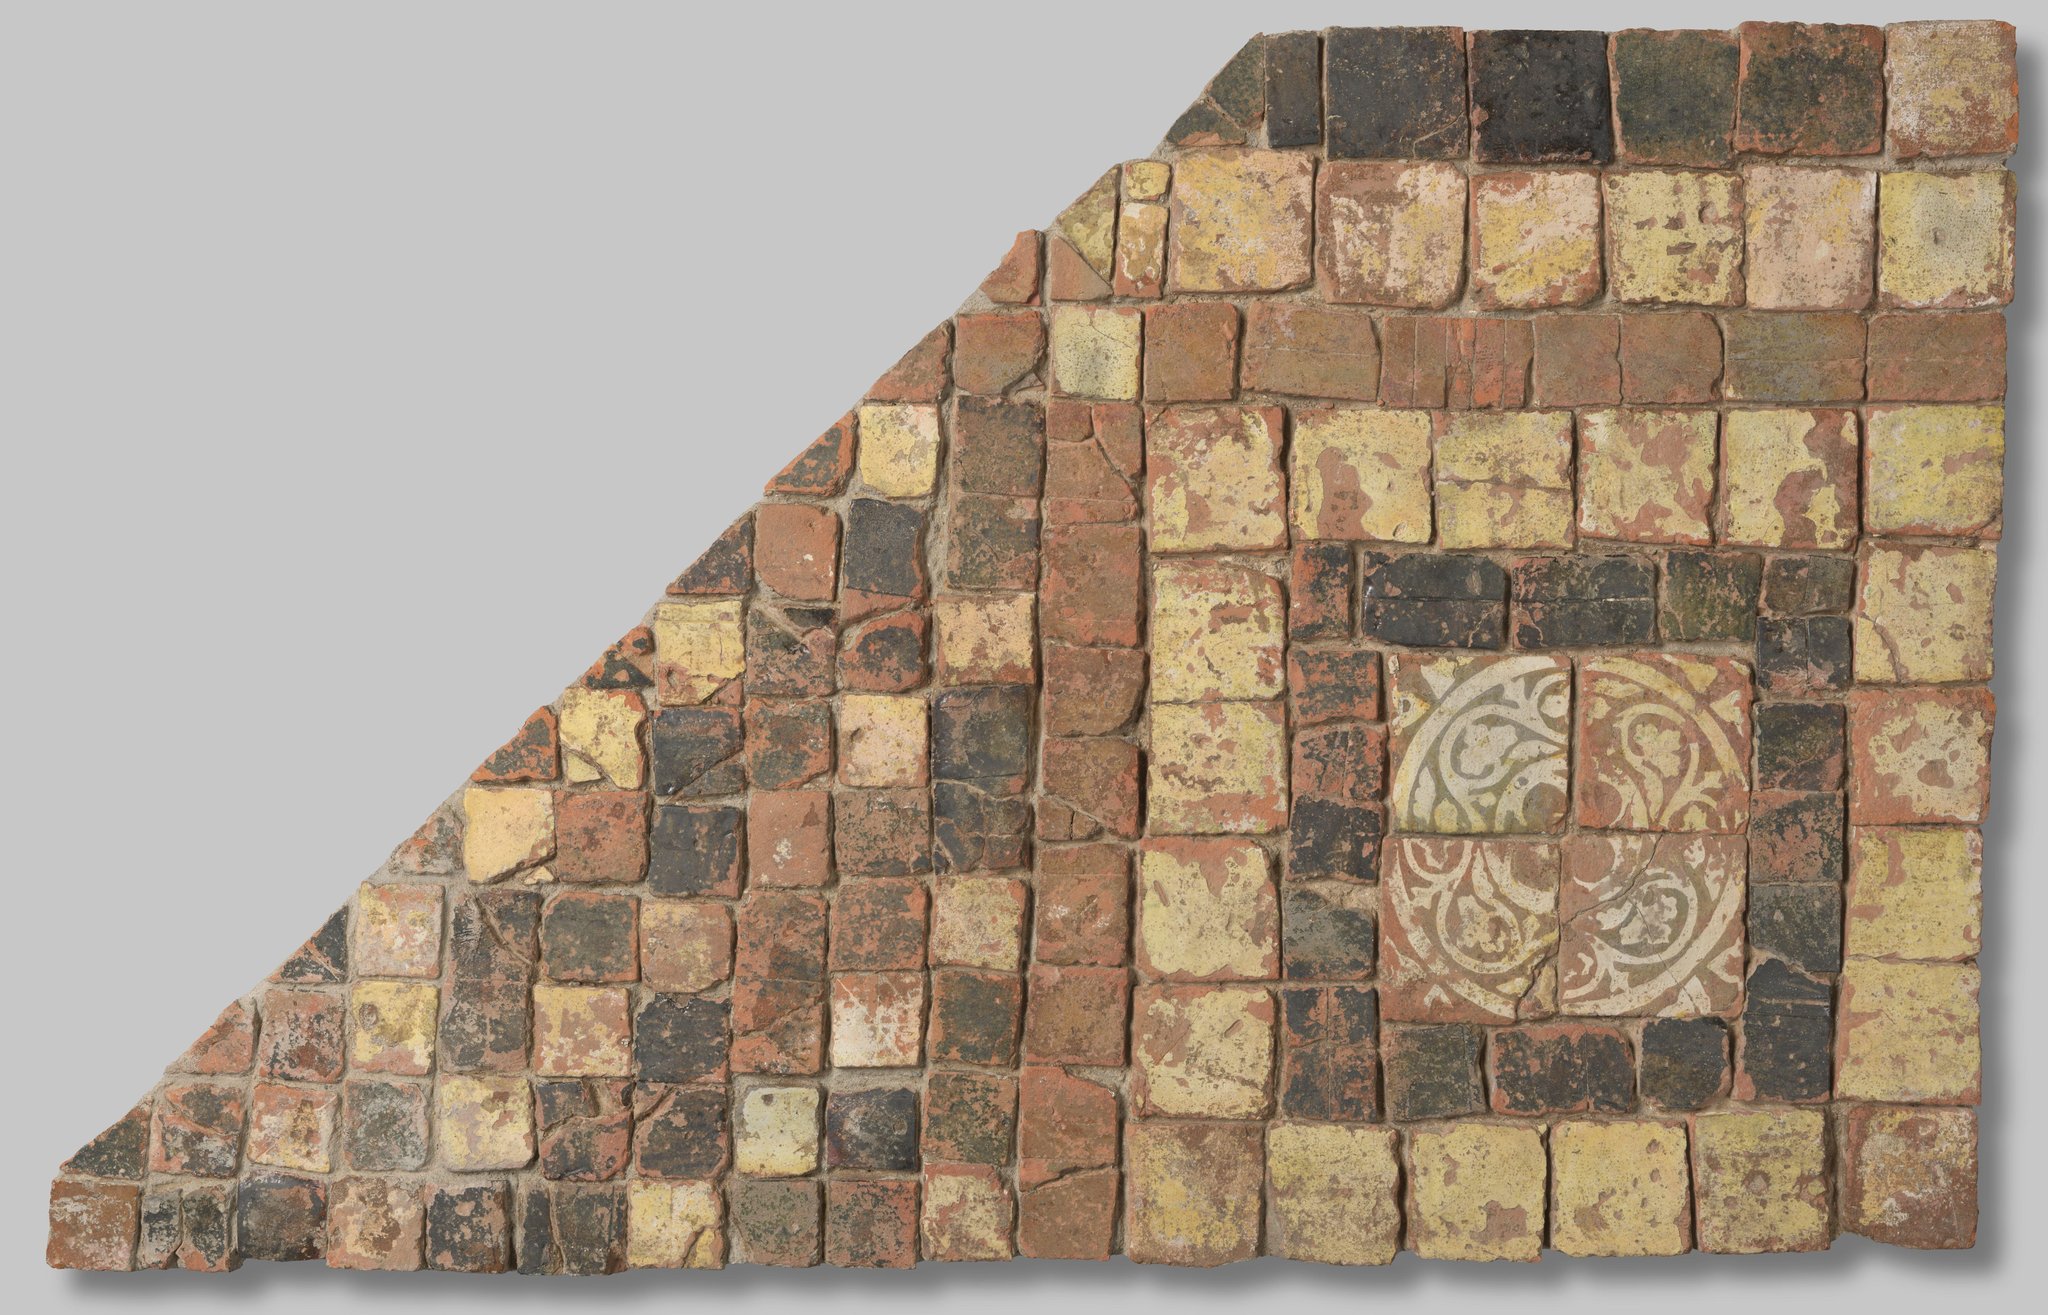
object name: tile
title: Deel van tegelvloer afkomstig uit de Nederlands Hervormde Kerk te Heukelum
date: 1325-1375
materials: ceramic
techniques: vitrification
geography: utrecht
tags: heukelum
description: Vierhoekig deel, met een schuine zijde, van vloer bestaand uit geglazuurde tegels in de kleuren zwart, groen, rood en geel. De tegels zijn geplakt op een dikke plaat.